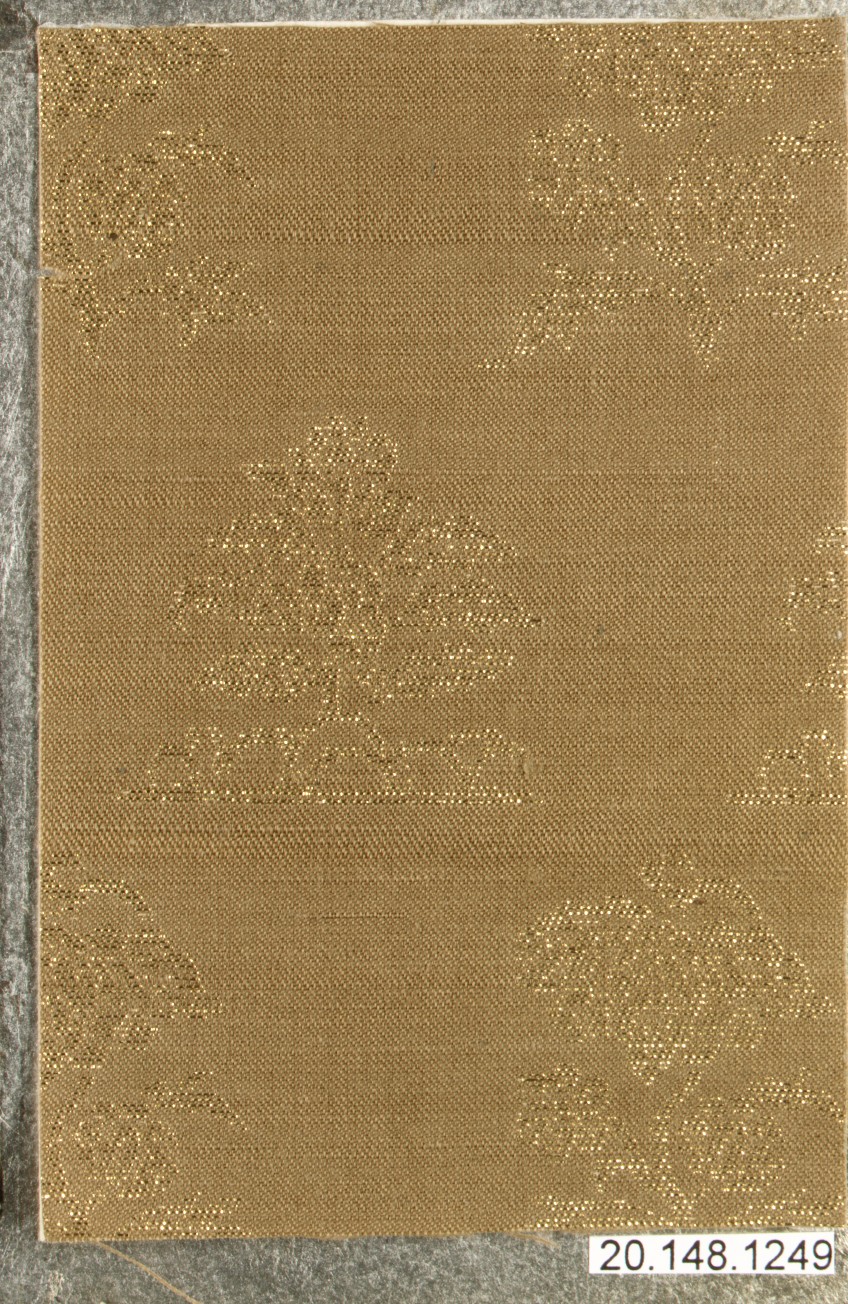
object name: piece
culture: japanese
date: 1801-1900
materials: silk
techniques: compound weave